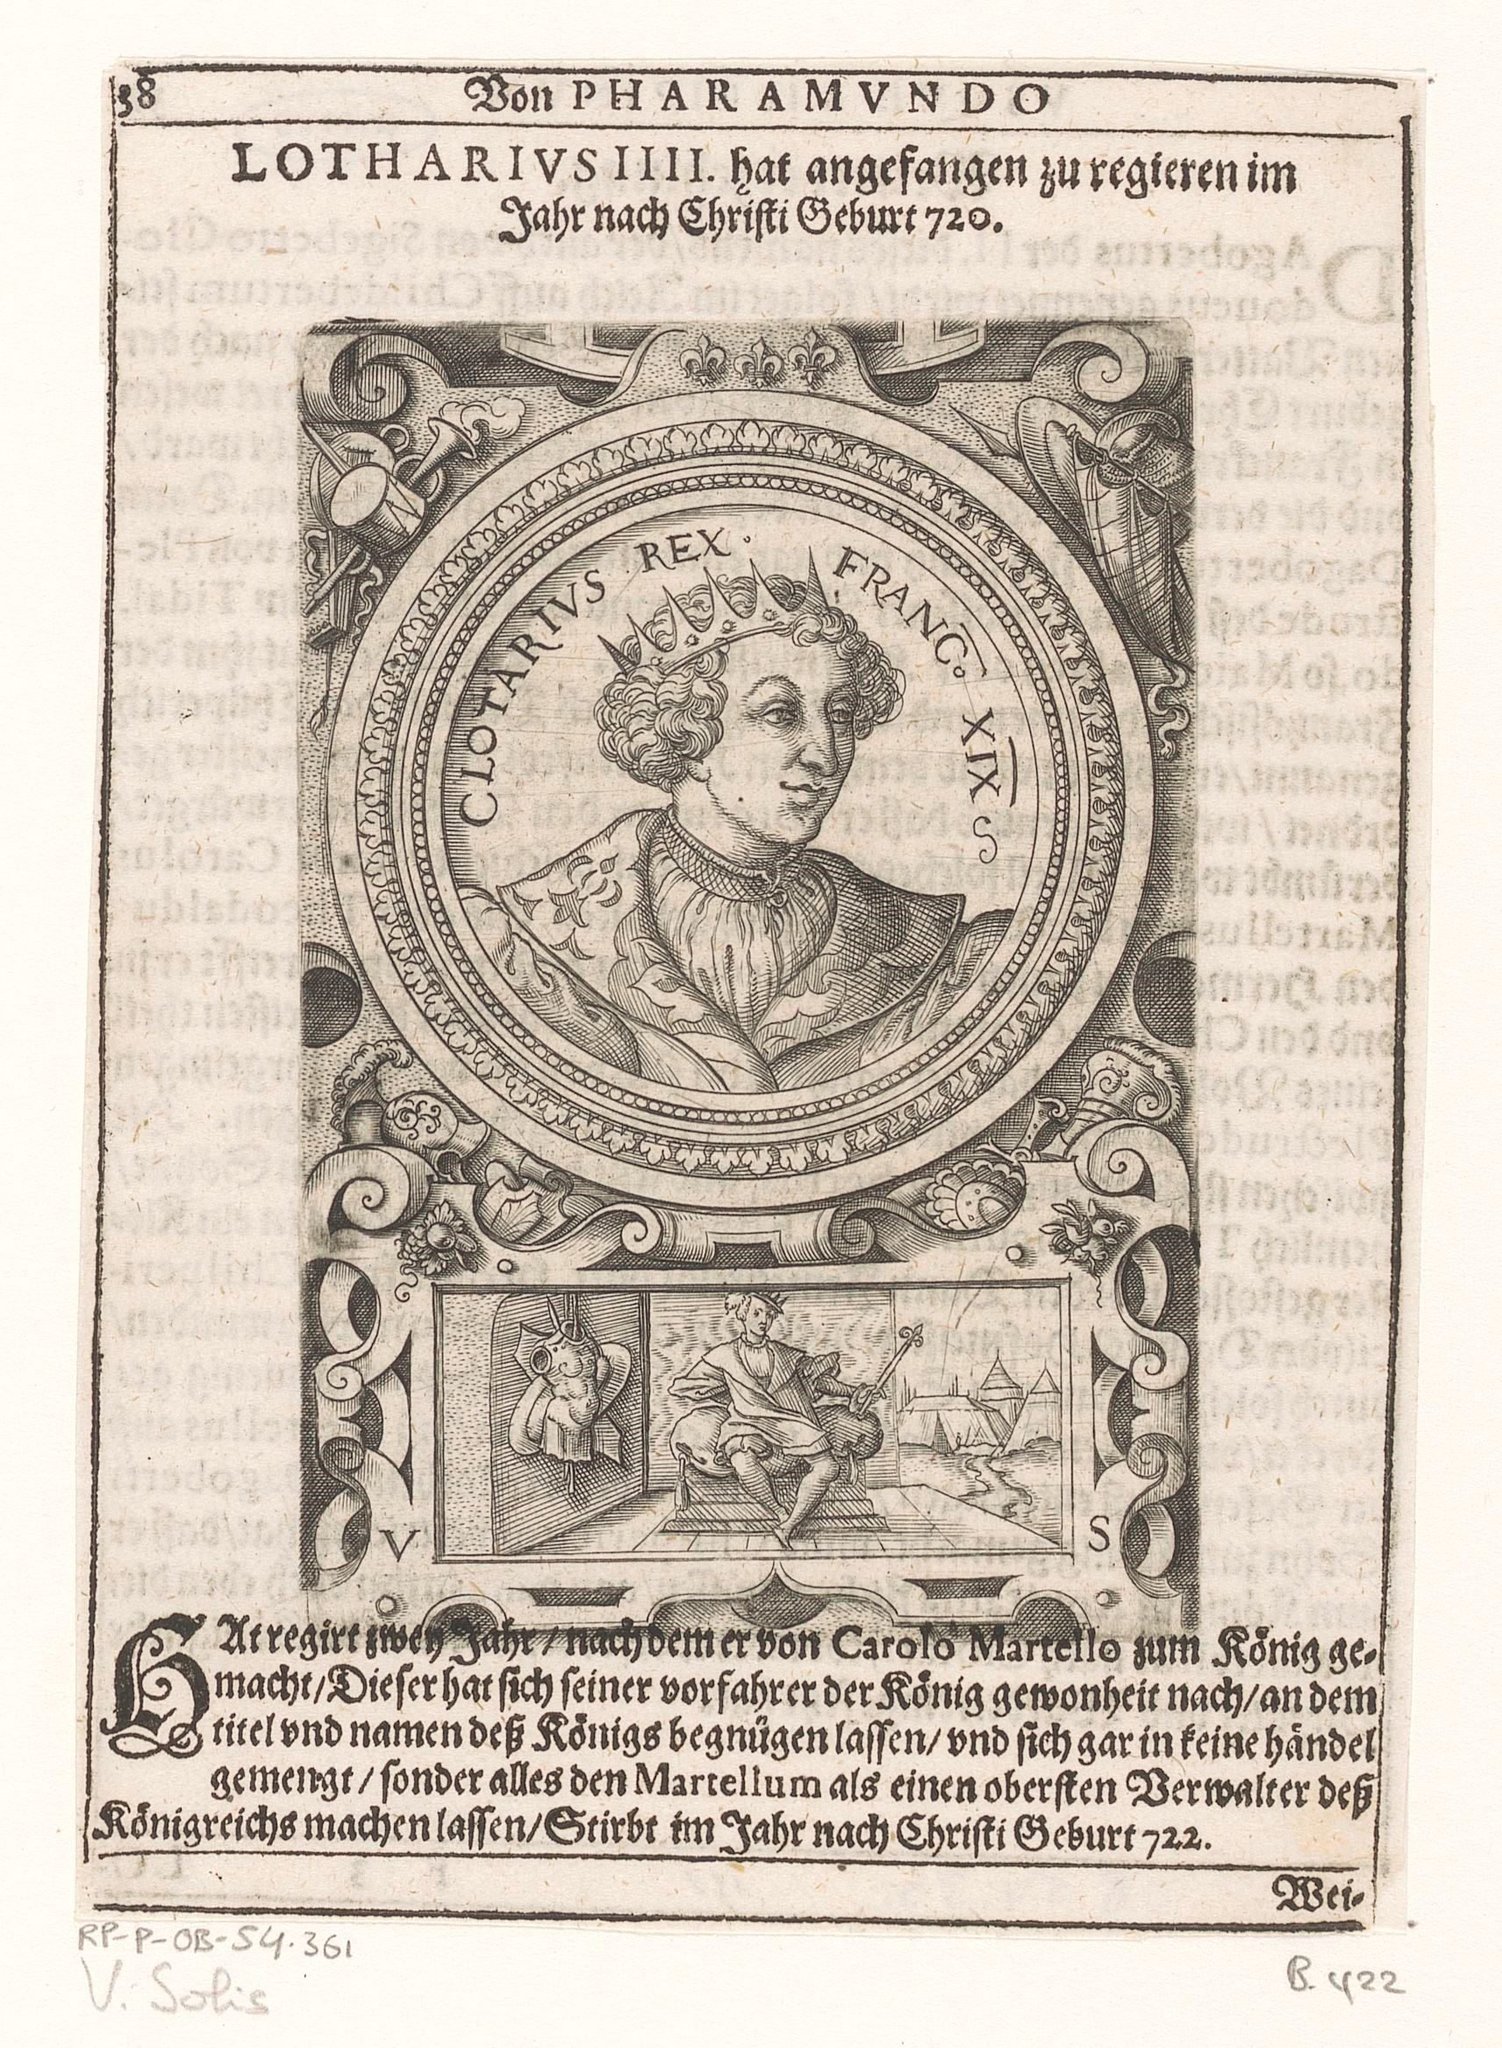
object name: print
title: Portret van Chlotharius IV, koning van Austrasië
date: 1598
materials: paper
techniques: engraving, etching, intaglio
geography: nuremberg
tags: scrollwork, strapwork ~ ornament, historical persons, ruler, sovereign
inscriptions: number: ‘158’, collector's mark: Lugt 2228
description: Prent afkomstig uit de publicatie: Michael Eizinger. Könige in Frankreich. Keulen: Johann Bussemacher, 1598, p. 38. De publicatie bevat prenten van Jost Amman en Virgil Solis.